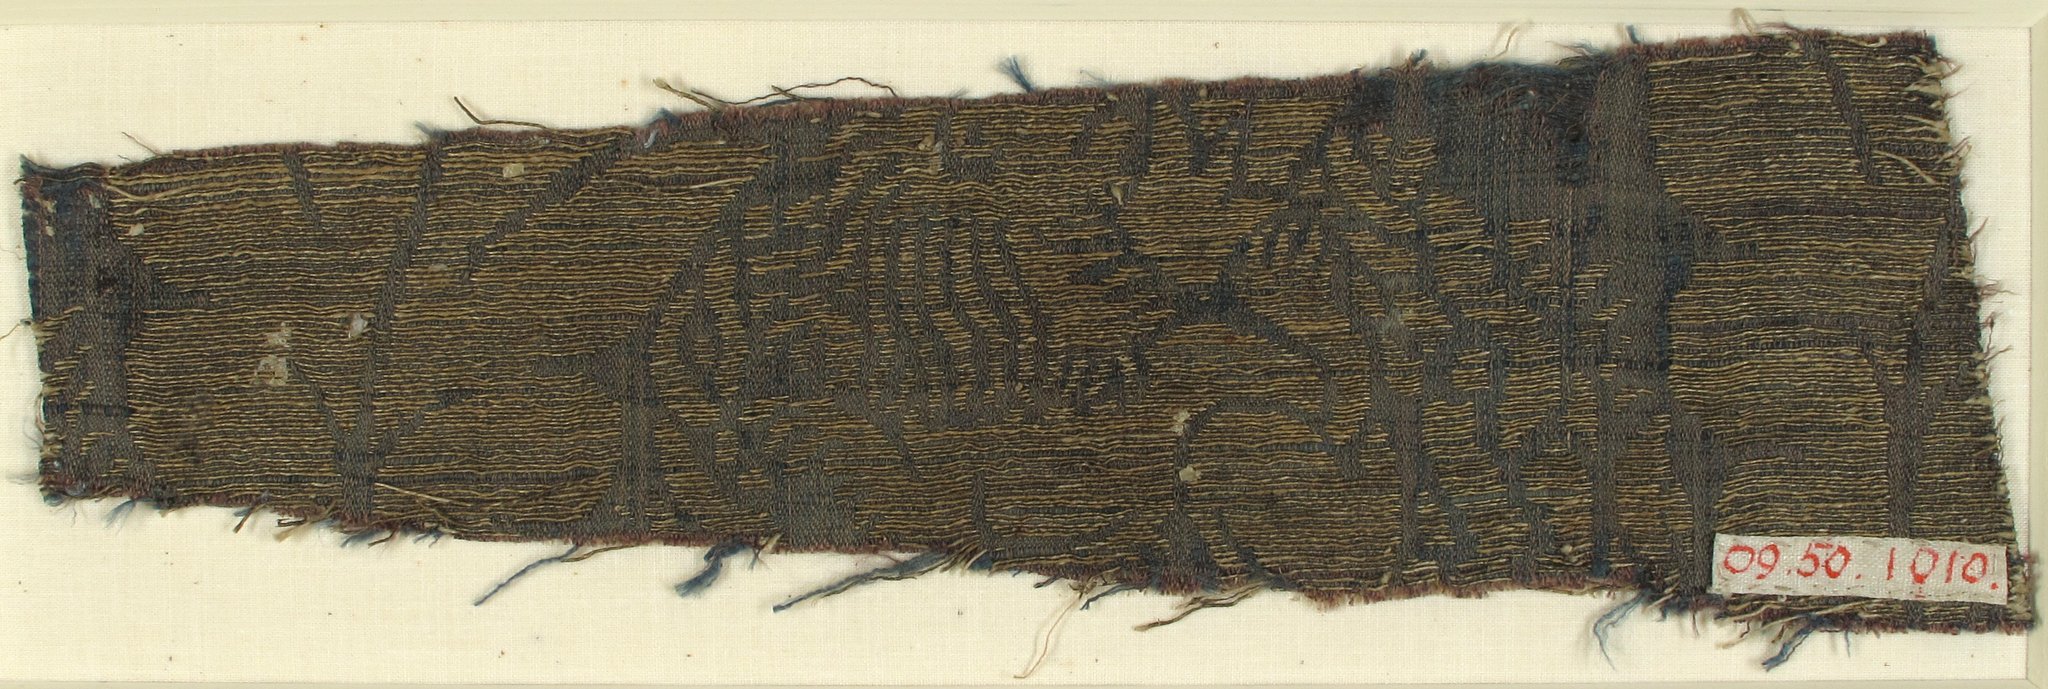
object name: textile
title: Textile with Lions and Peacocks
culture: italian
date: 1401-1500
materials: gold thread, silk